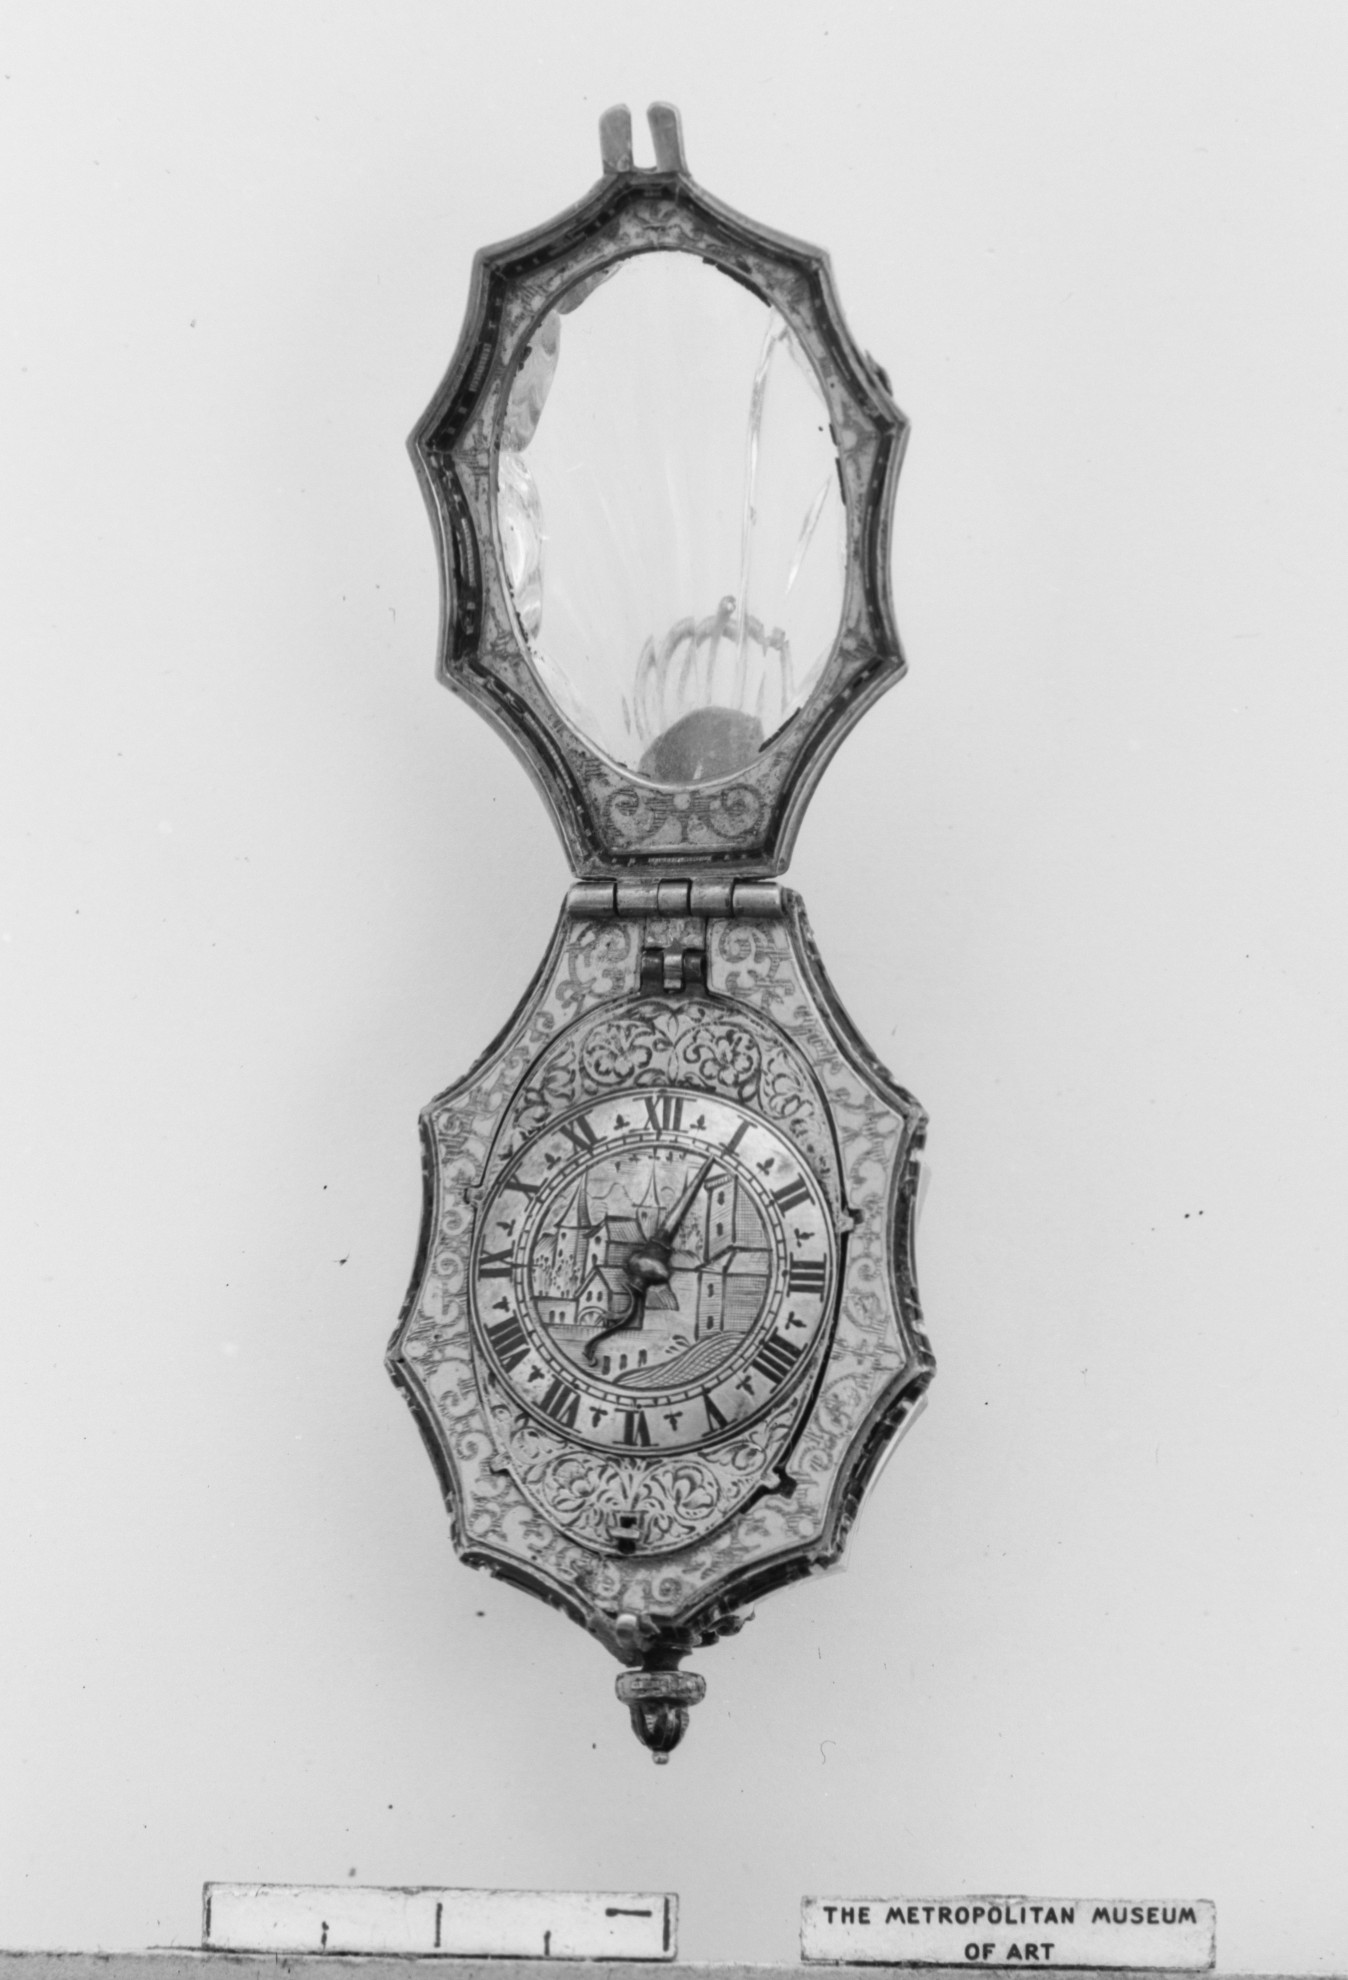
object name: watch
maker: jean gaspard du val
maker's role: maker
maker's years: 1570-1630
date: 1650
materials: enamel, metal, quartz, silver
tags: houses